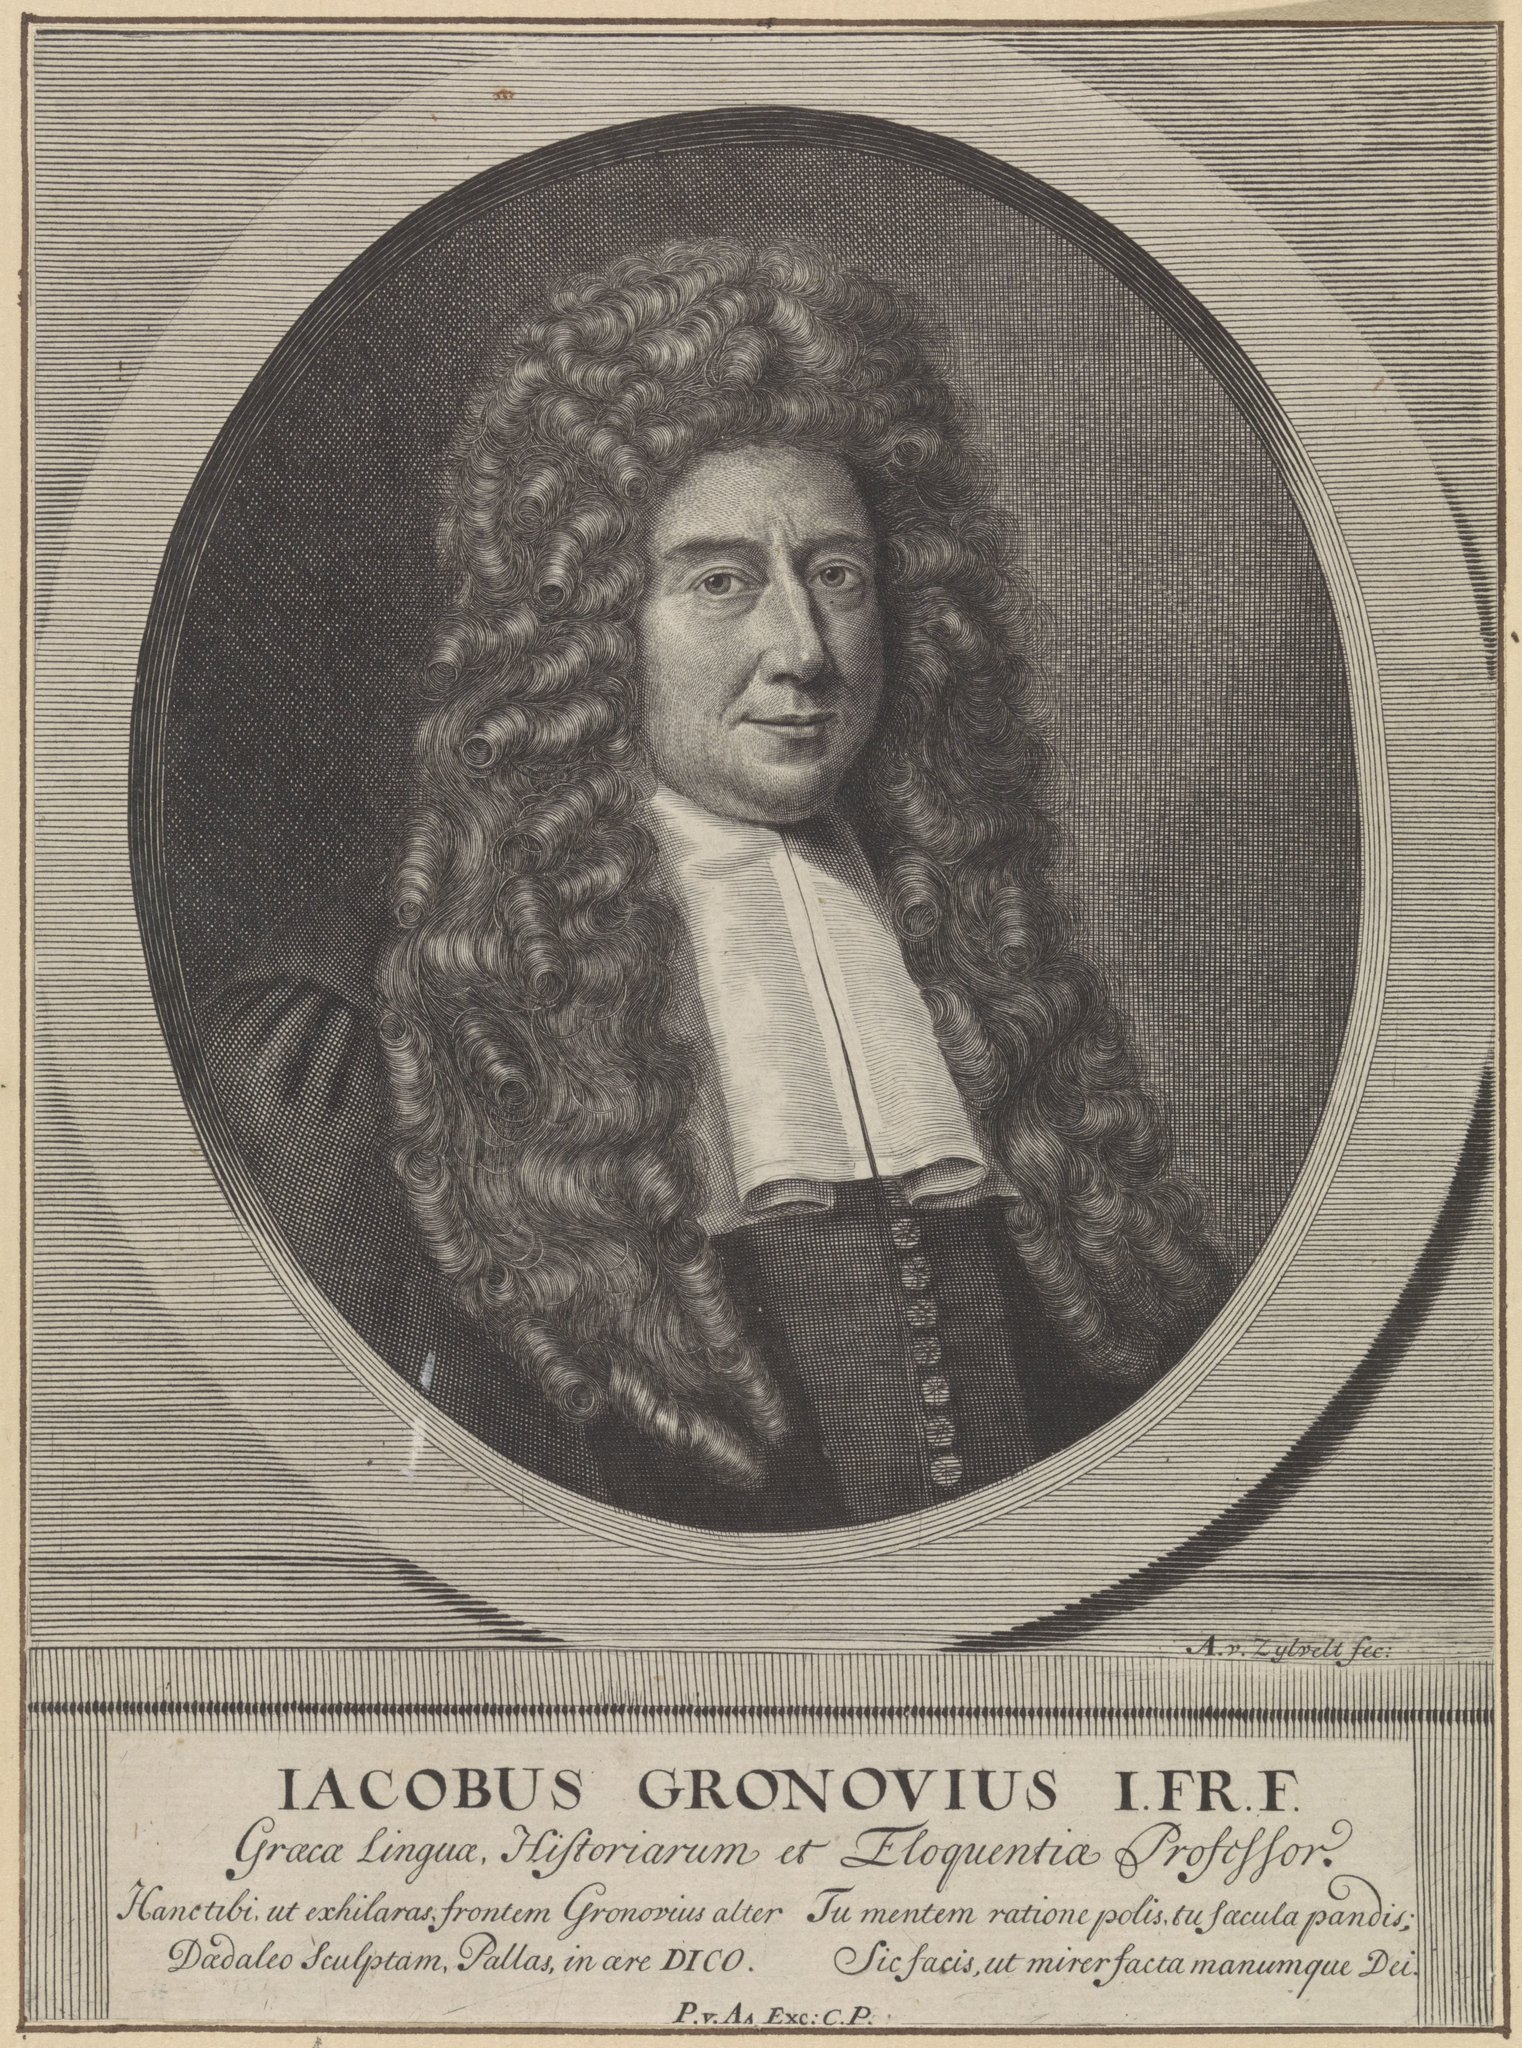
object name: book illustration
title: Portret van Jacob Gronovius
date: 1693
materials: paper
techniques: engraving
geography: leiden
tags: deventer, leiden, jacob gronovius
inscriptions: collector's mark: Lugt 2228, title: ‘IACOBUS GRONOVIUS I.FR.F. / Graecae Linguae, Historiarum et Eloquentiae Professor....’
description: Portret van Jacobus Gronovius, hoogleraar in het Grieks en de welsprekendheid te Leiden, gekleed in toga met witte bef. Onder het portret zijn naam, functie en vier tekstregels in het Latijn.